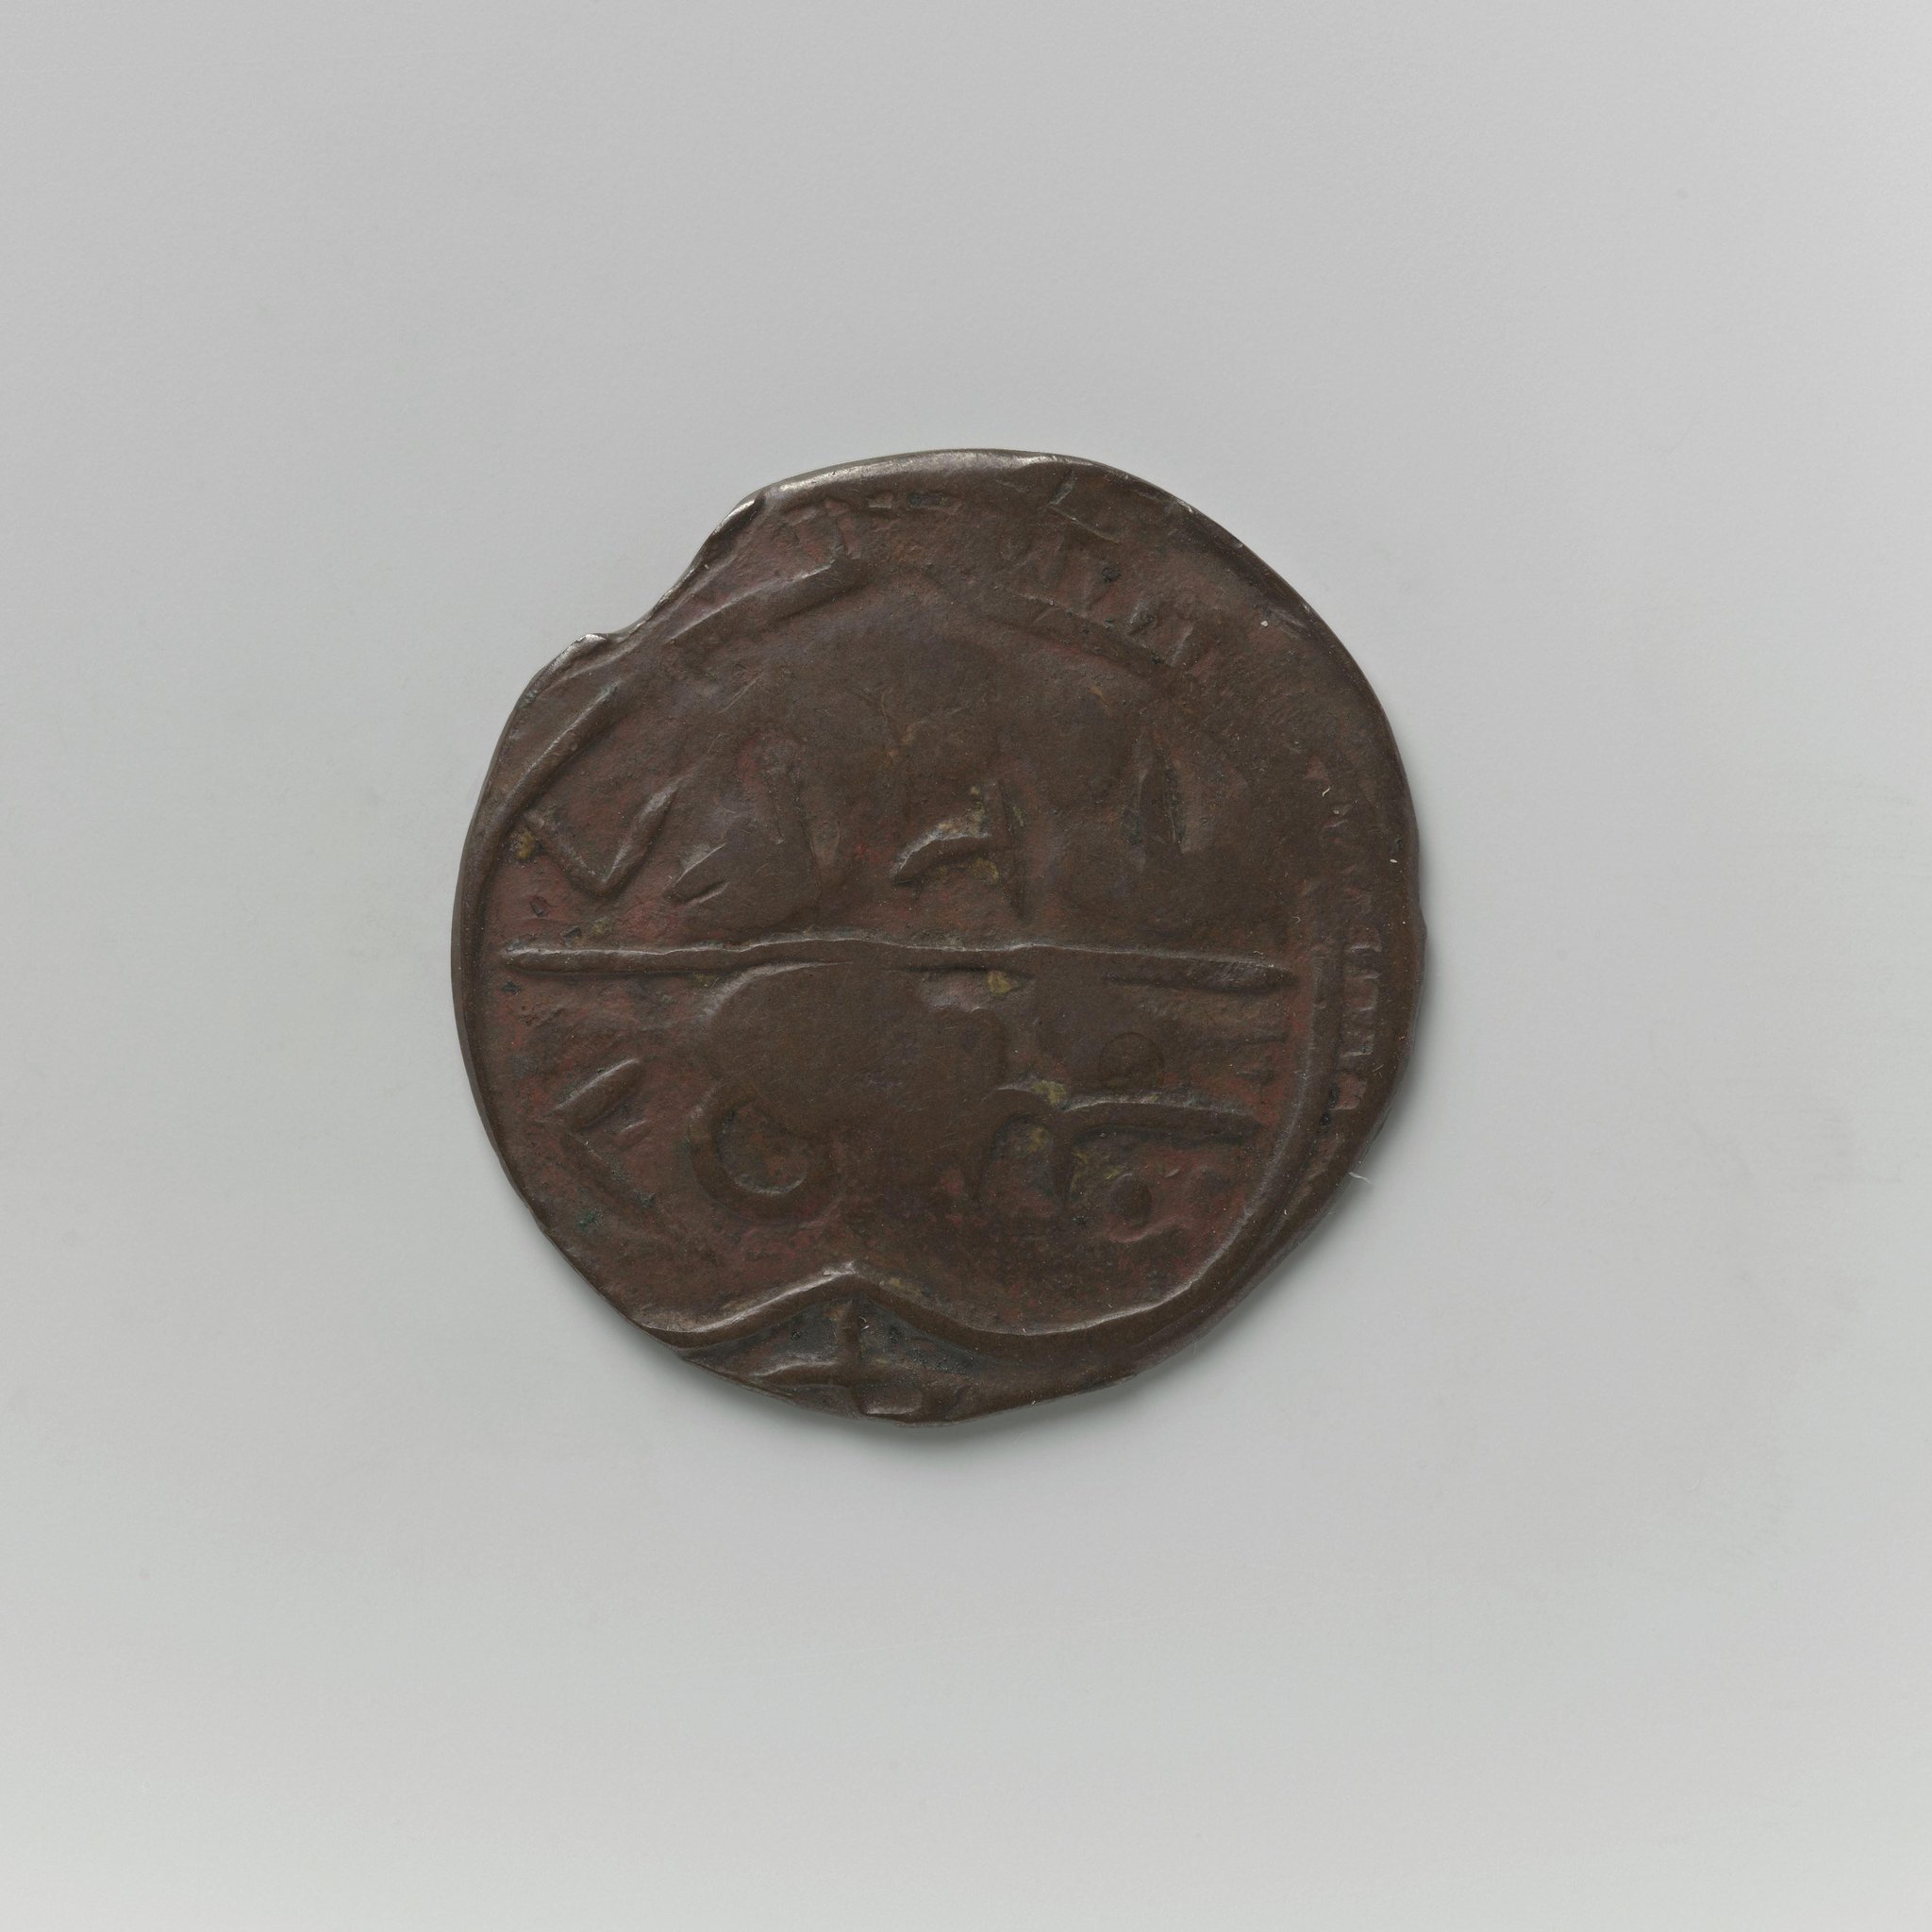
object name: coin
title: Maloeka (Borneo), Alexander Hare, duit,1813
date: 1813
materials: copper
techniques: striking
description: Koperen munt. Voorzijde: in een hartvormig schild, waarop teken in de vorm van een vier, op eeen regel waarde-aanduiding in het Maleis: doeit in Arabische lettertekens, waaronder jaartal 1228 in Islamitische tijdsrekening en in Arabische cijfers. Keerzijde: versiering in de vorm van een bloem. Gladde rand.